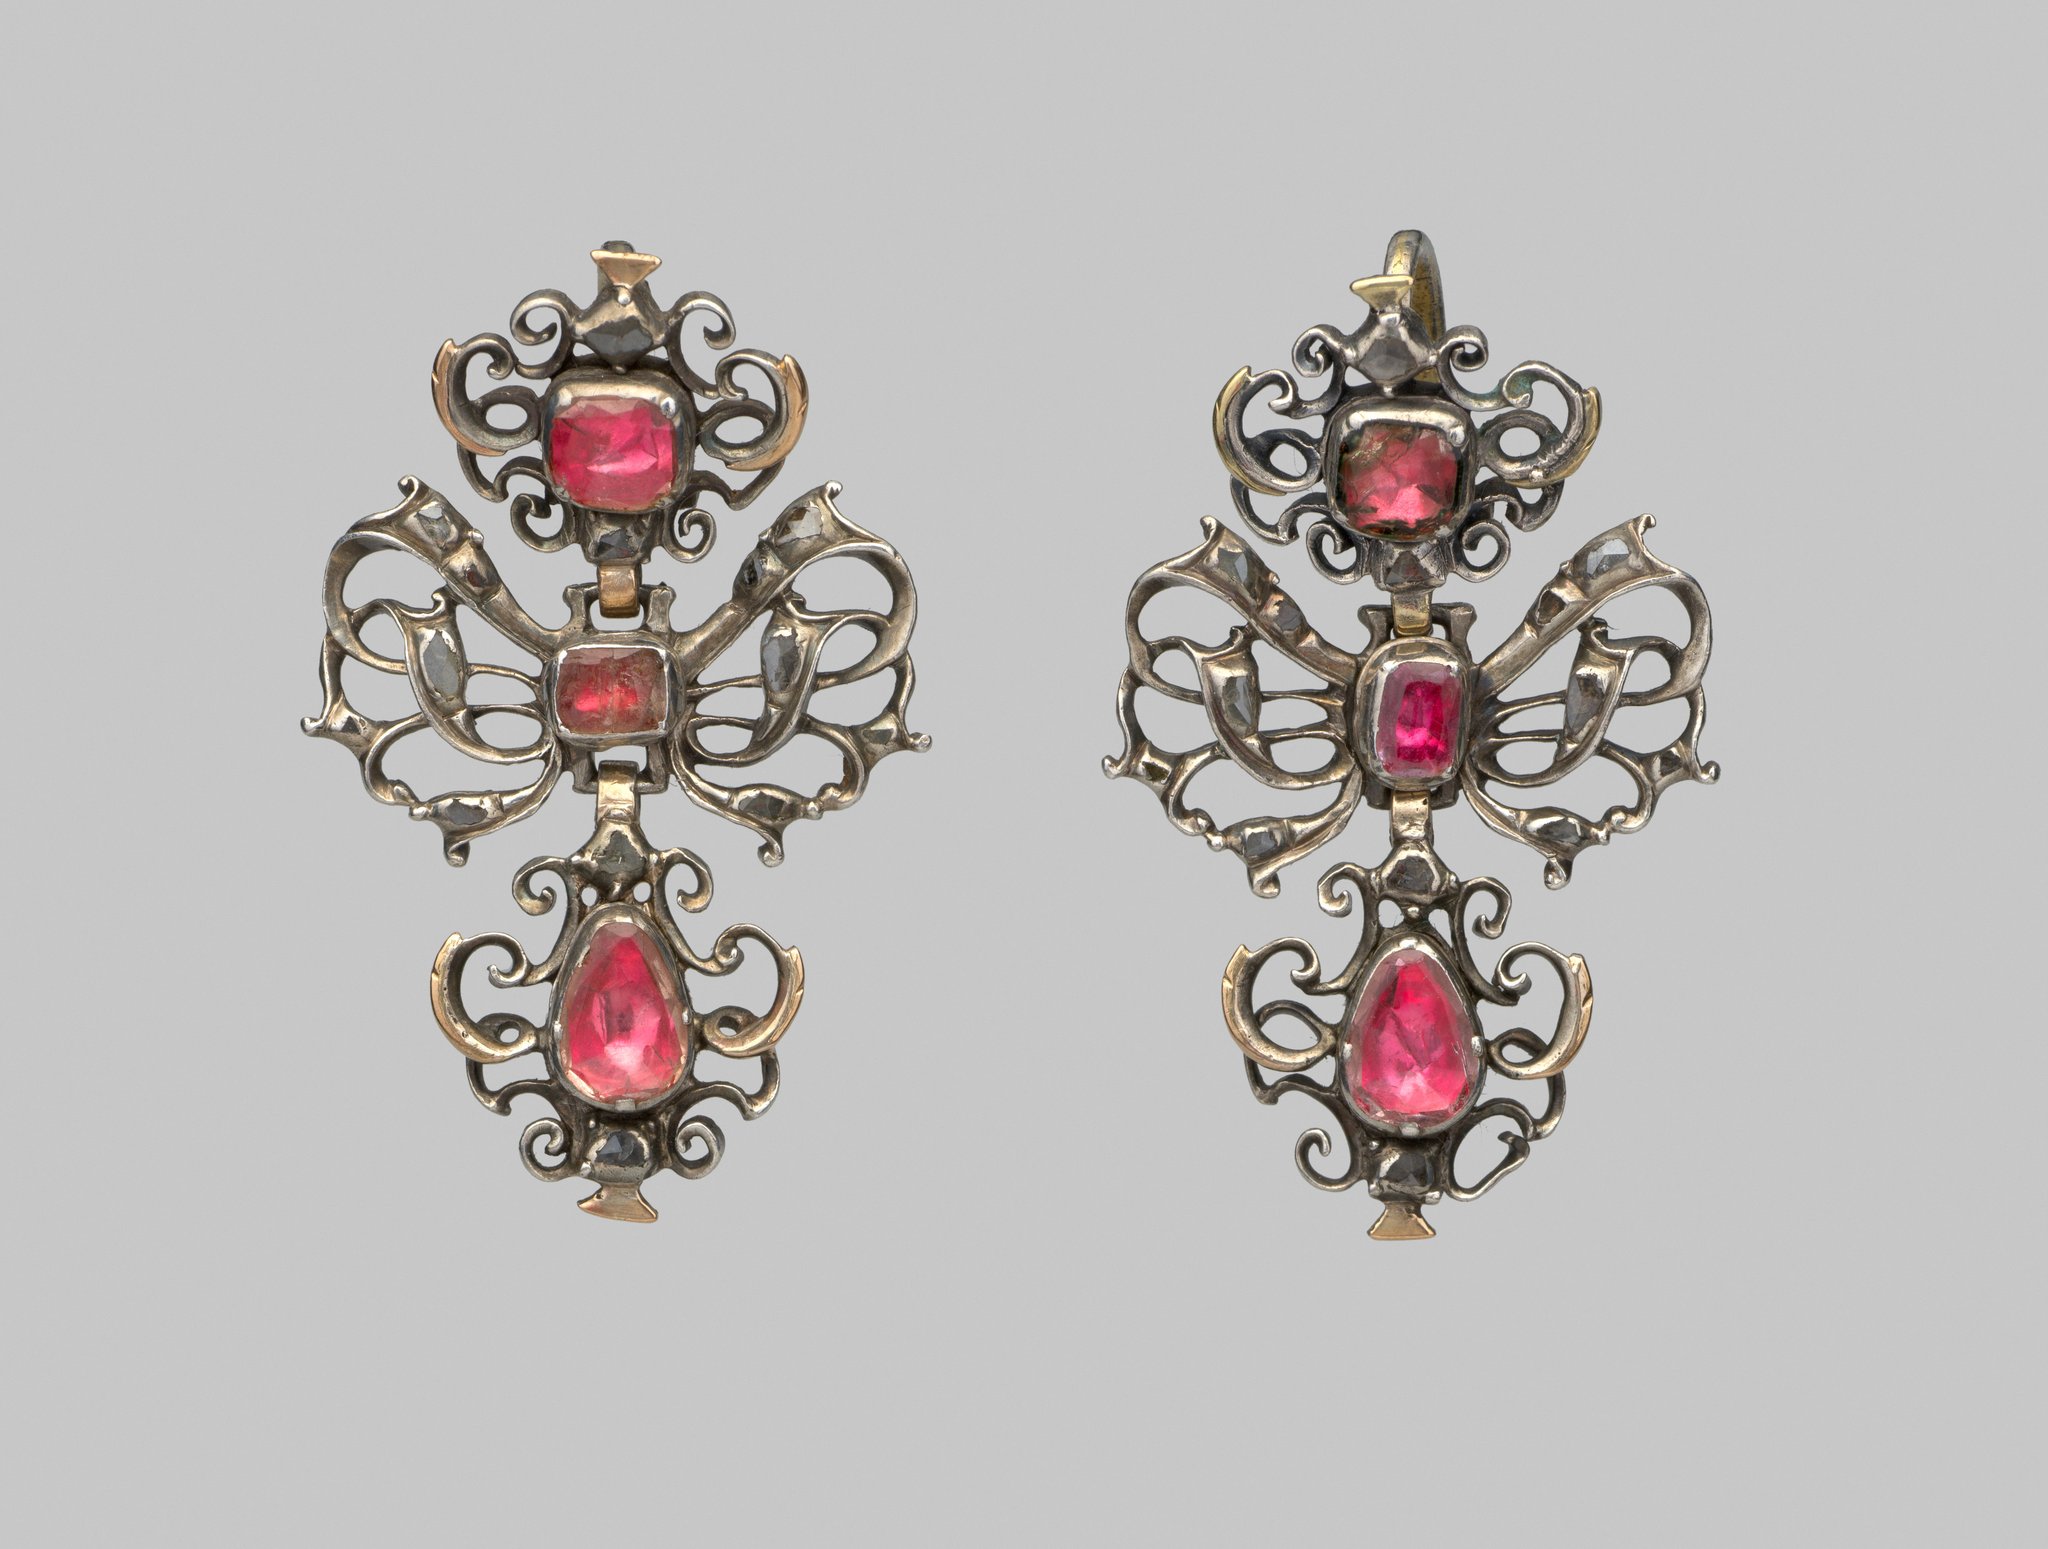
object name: earring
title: Pair of earrings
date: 1701-1800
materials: silver